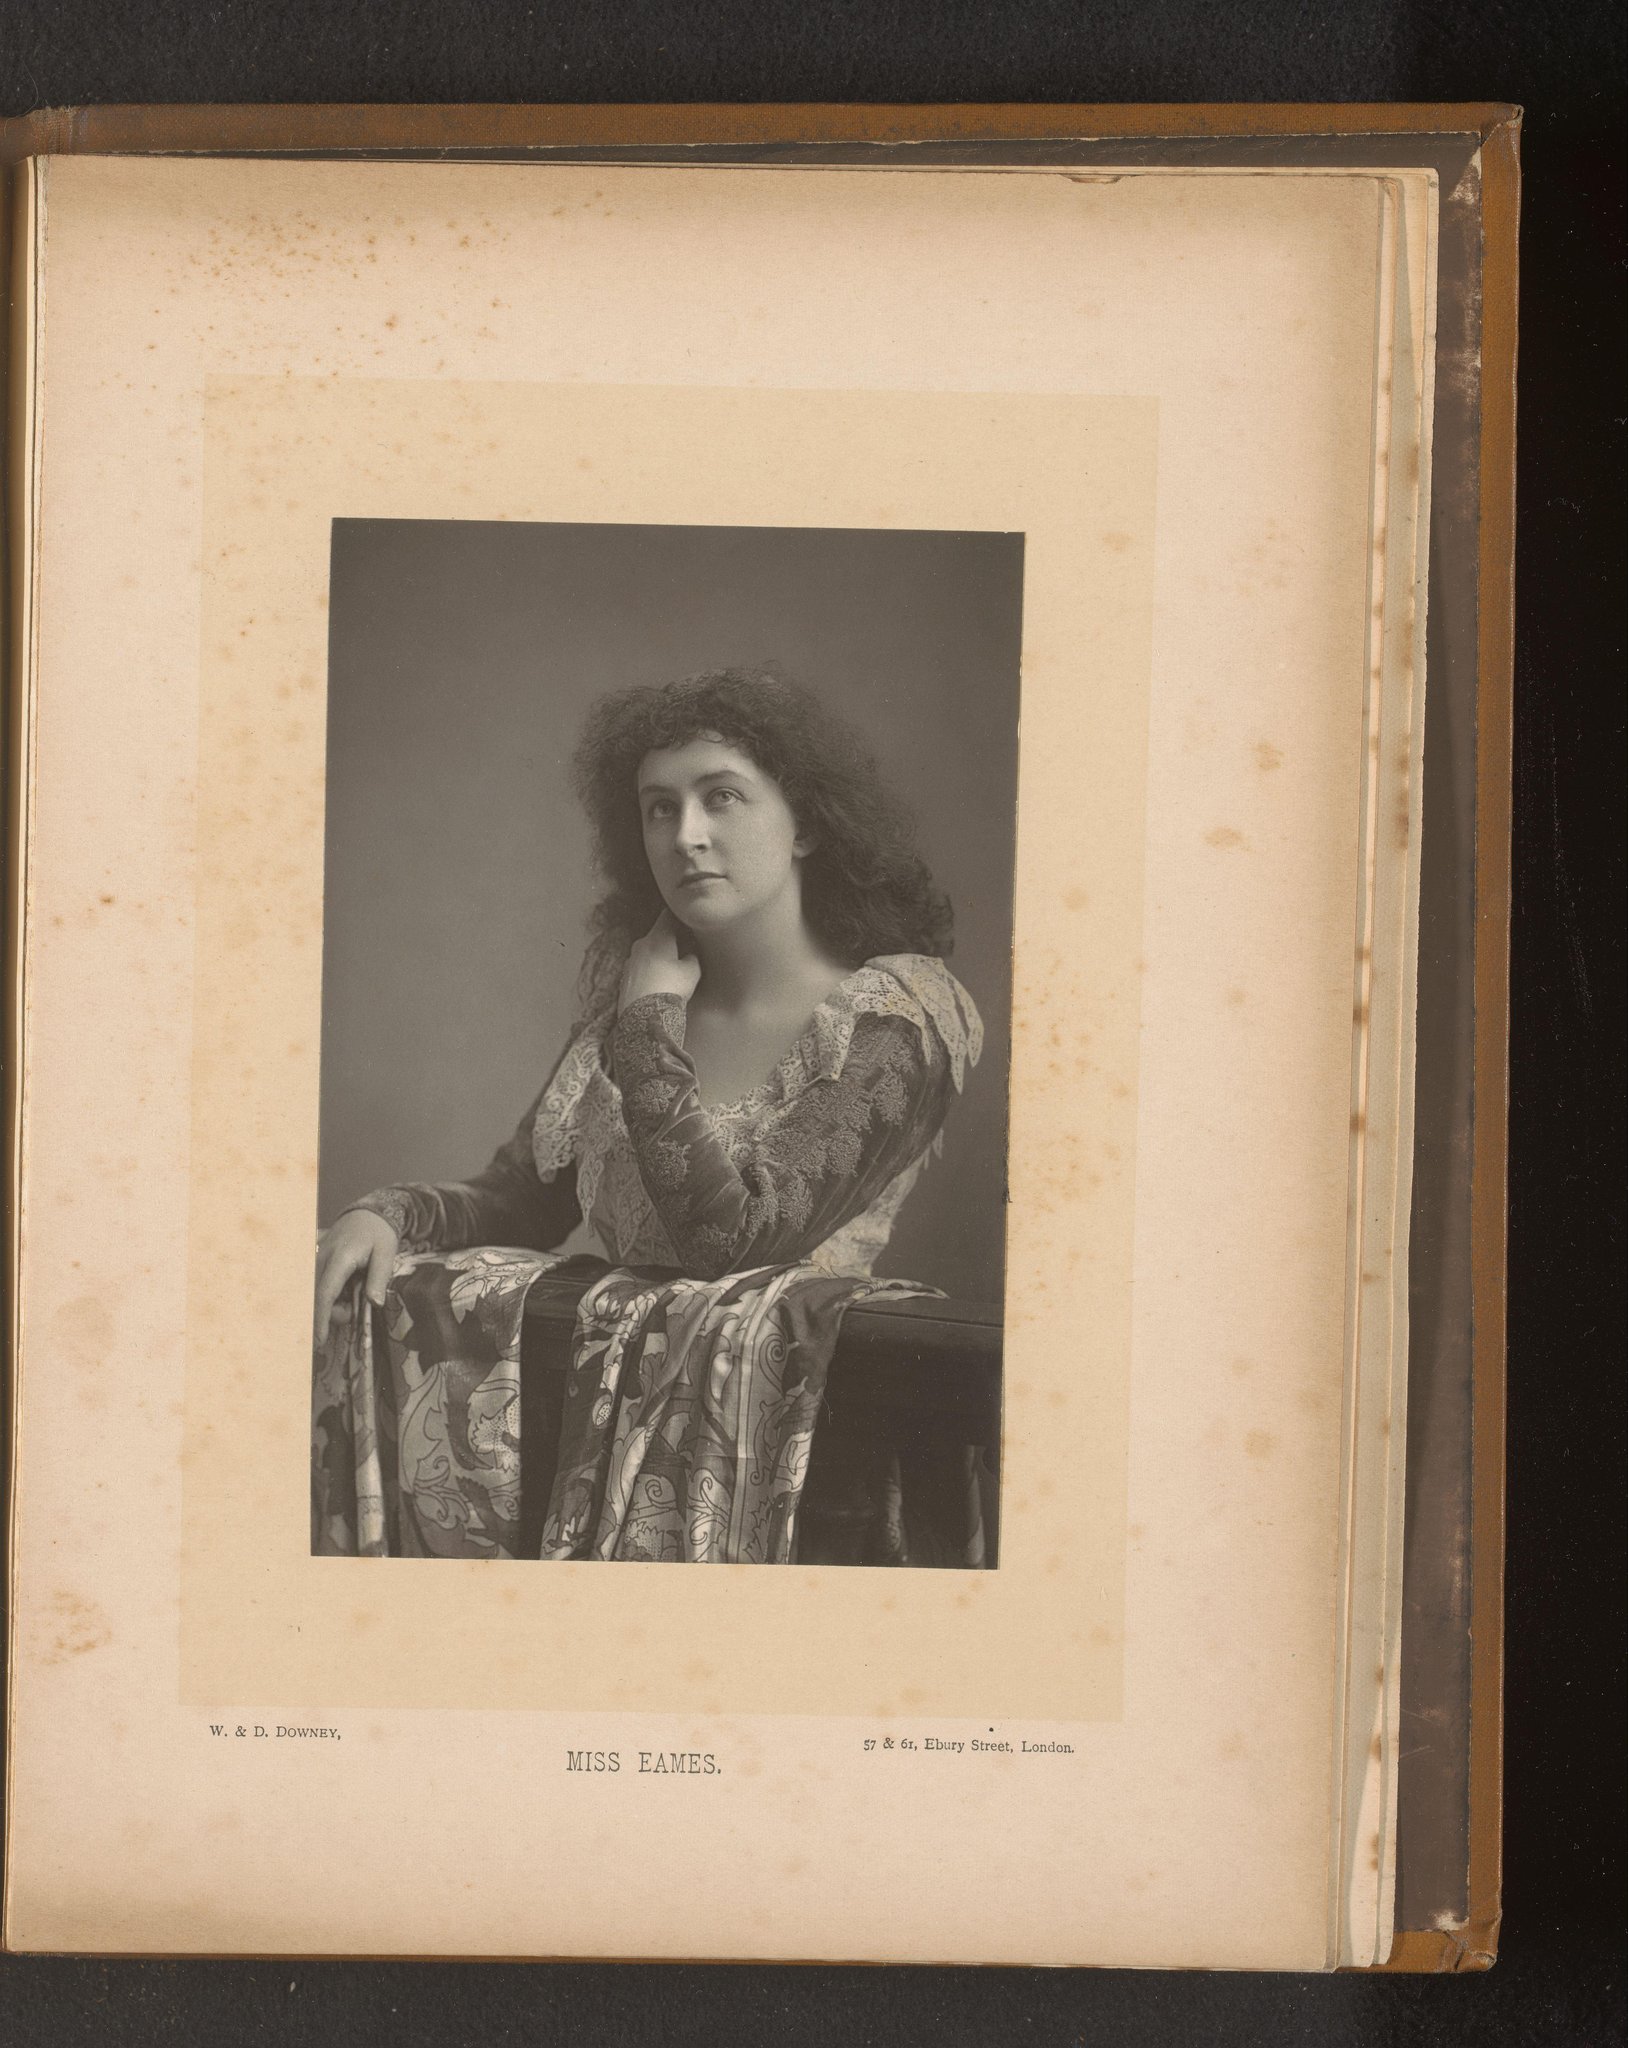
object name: photomechanical print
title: Miss Eames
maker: Anonymous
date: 1881-1891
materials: paper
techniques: woodburytype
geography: london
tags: opera-singer (female)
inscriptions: inscription: ‘57 & 61, Elbury Street, London.’